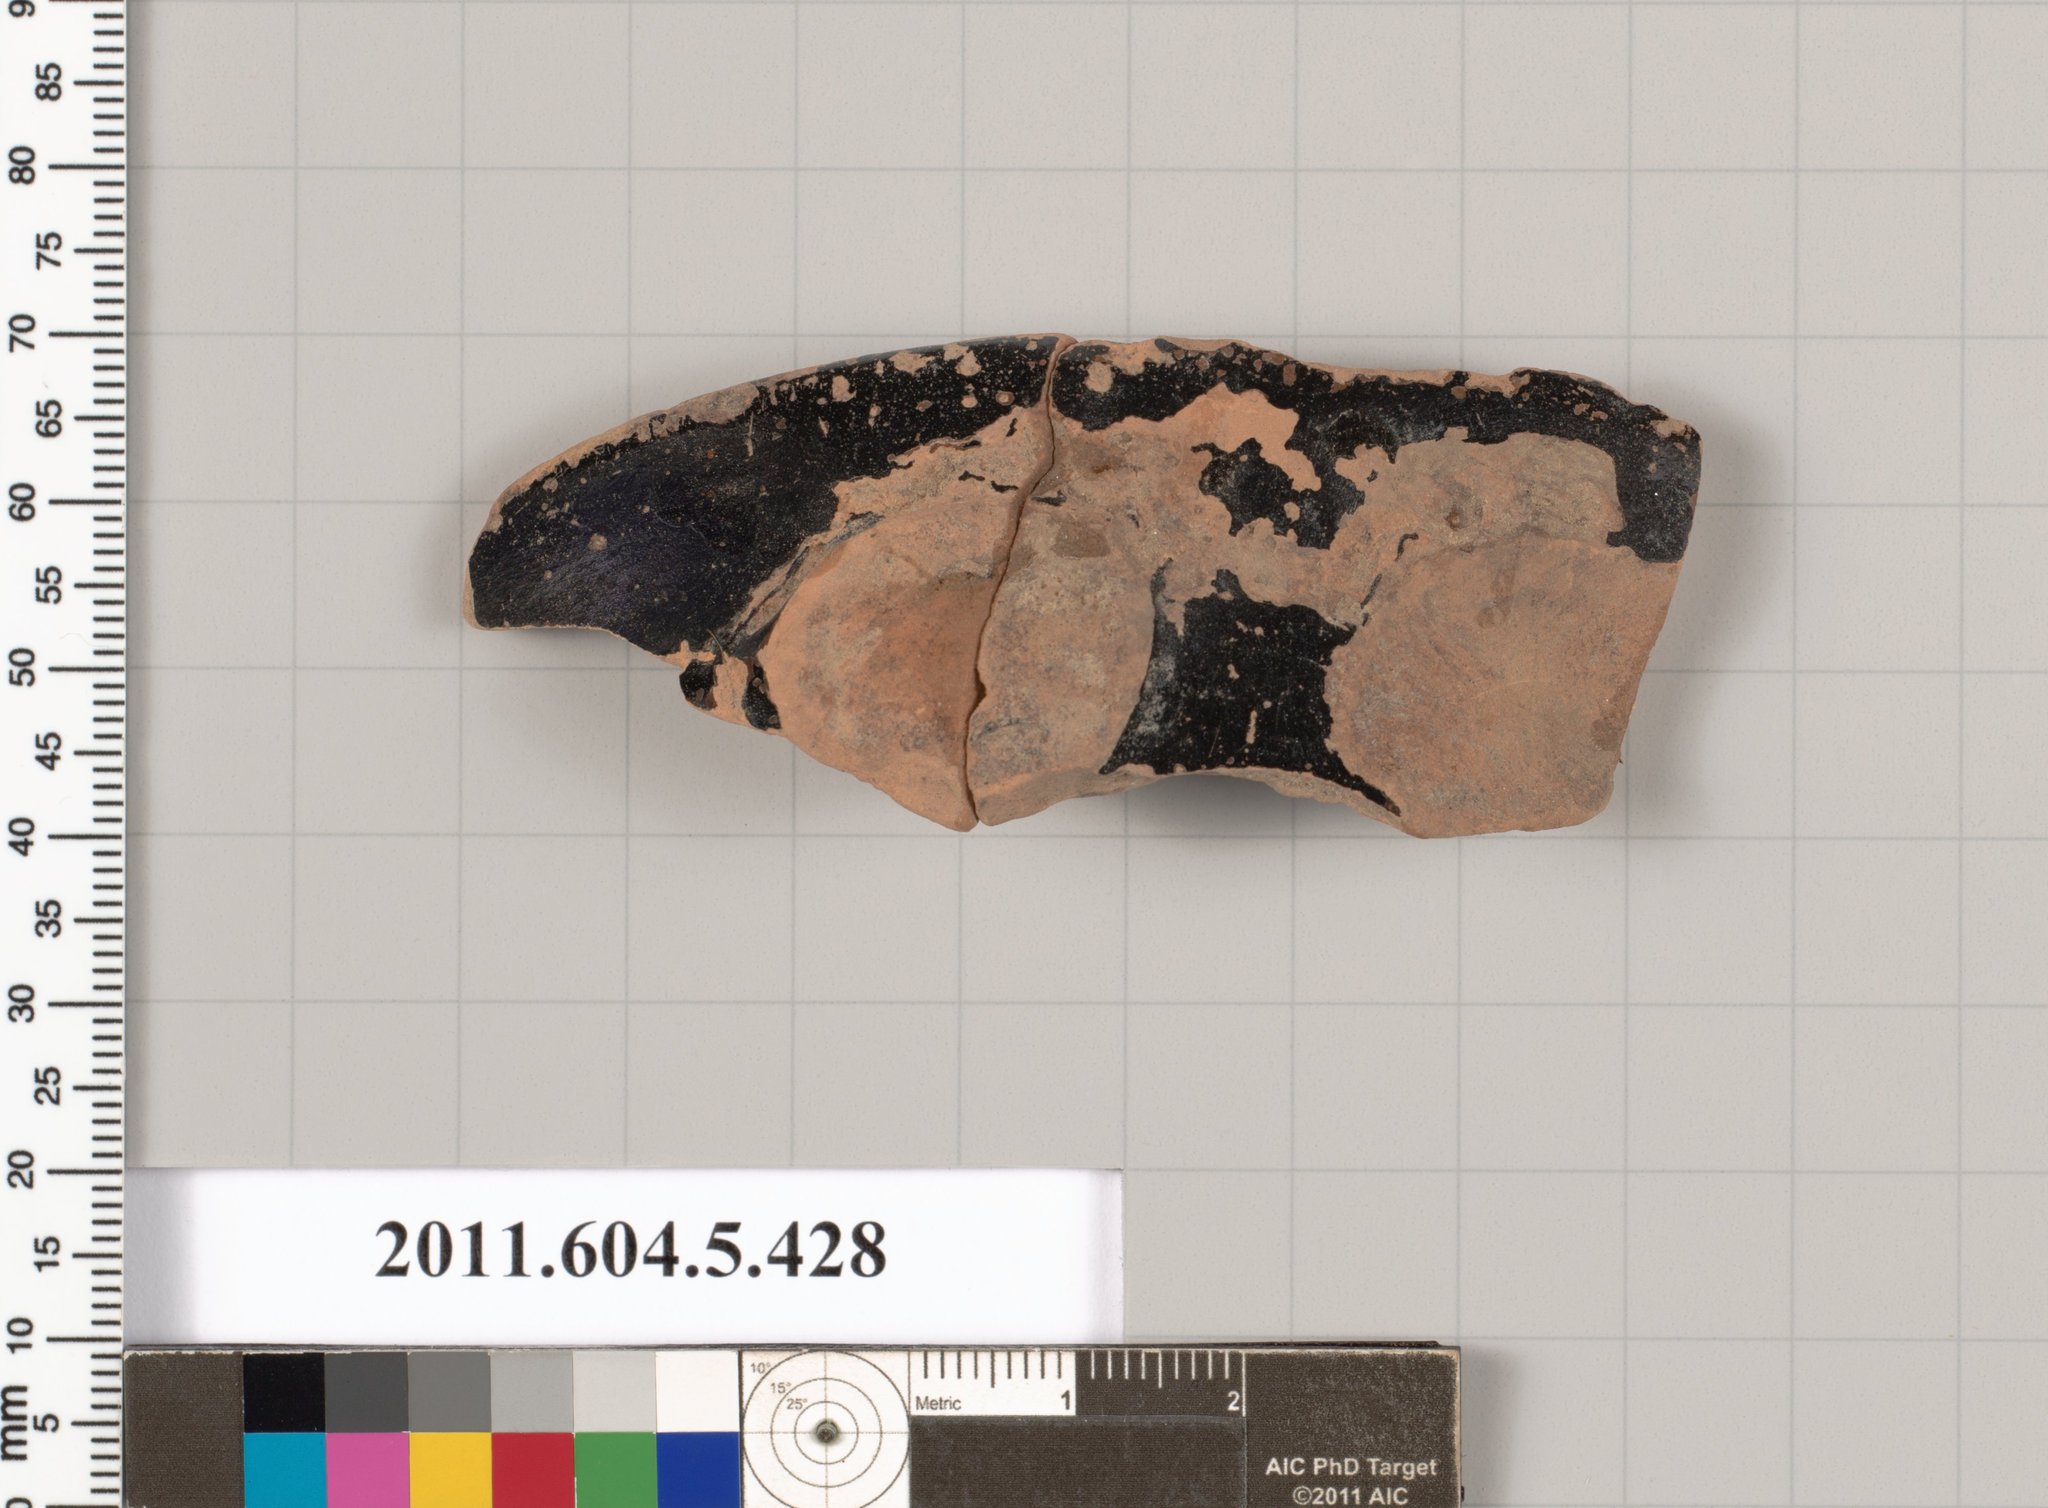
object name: kylix fragment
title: Terracotta rim fragment of a kylix (drinking cup)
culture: greek, attic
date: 600-401 BCE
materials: terracotta